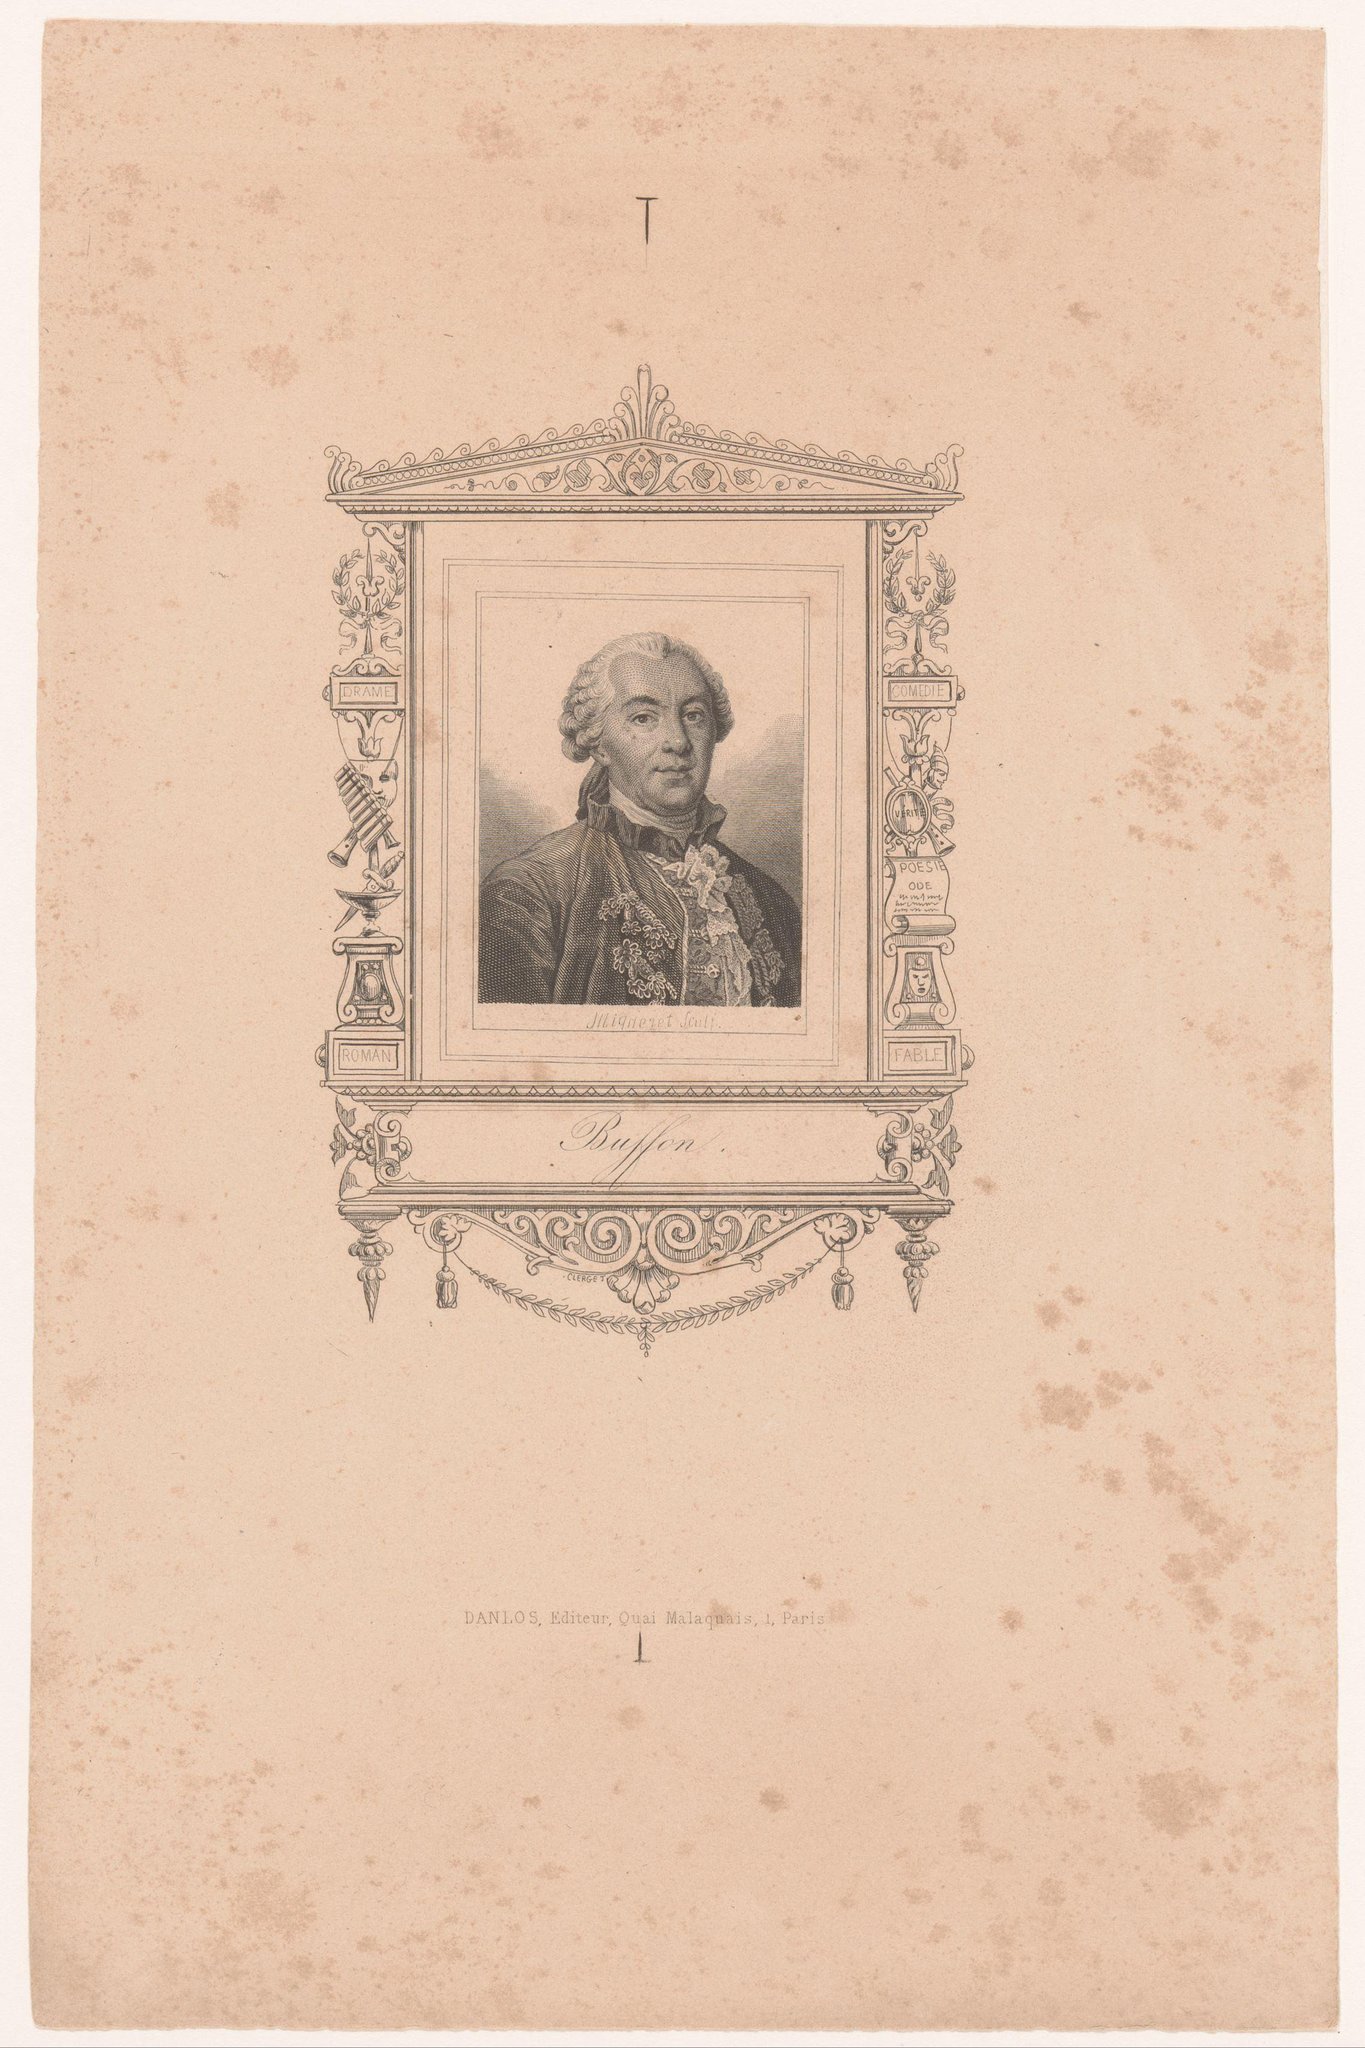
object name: print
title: Buffon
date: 1822-1840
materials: paper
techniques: etching, engraving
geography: paris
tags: paris, georges-louis leclerc de buffon (graaf), historical persons, nobility and patriciate; chivalry, knighthood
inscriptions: collector's mark: Lugt 2228